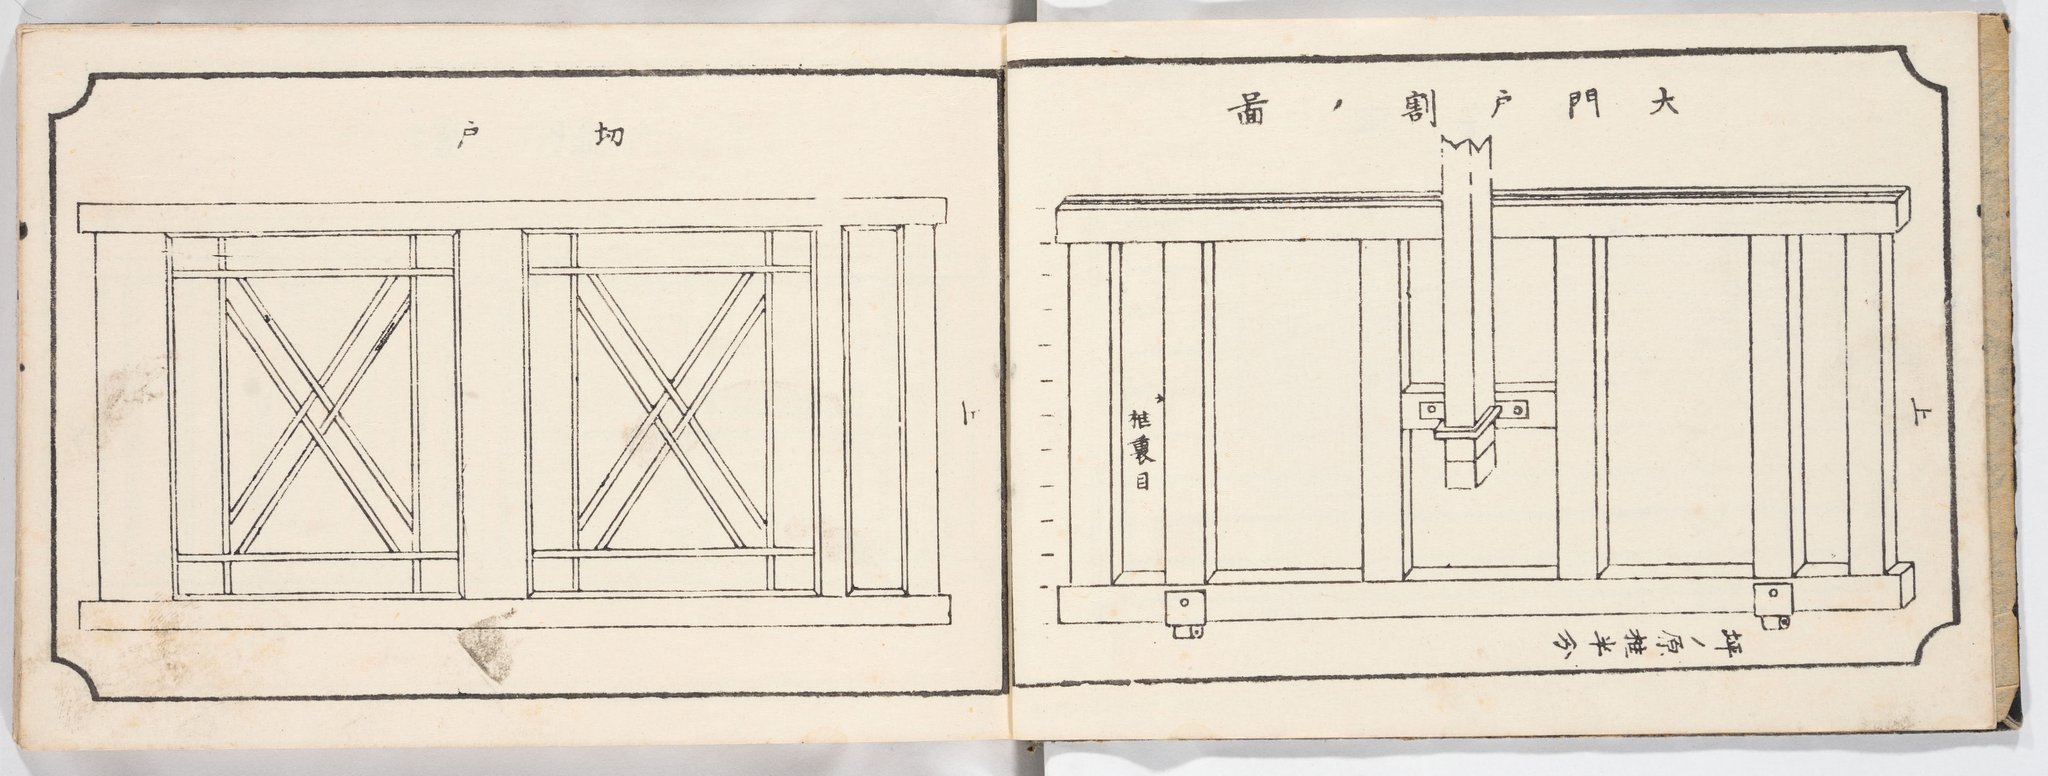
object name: illustrated book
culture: japanese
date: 1893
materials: ink, paper